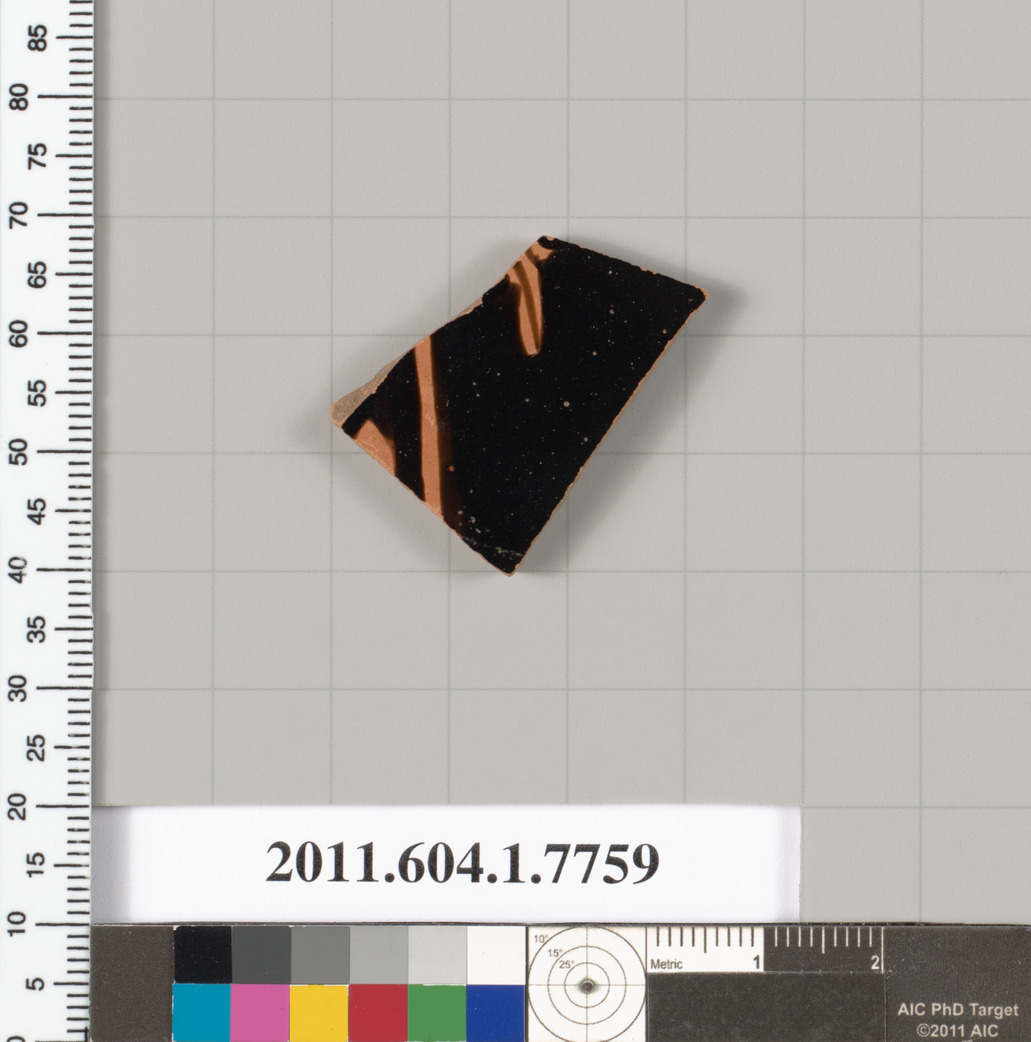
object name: kylix fragment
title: Terracotta fragment of a kylix (drinking cup)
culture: greek, attic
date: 460-450 BCE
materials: terracotta